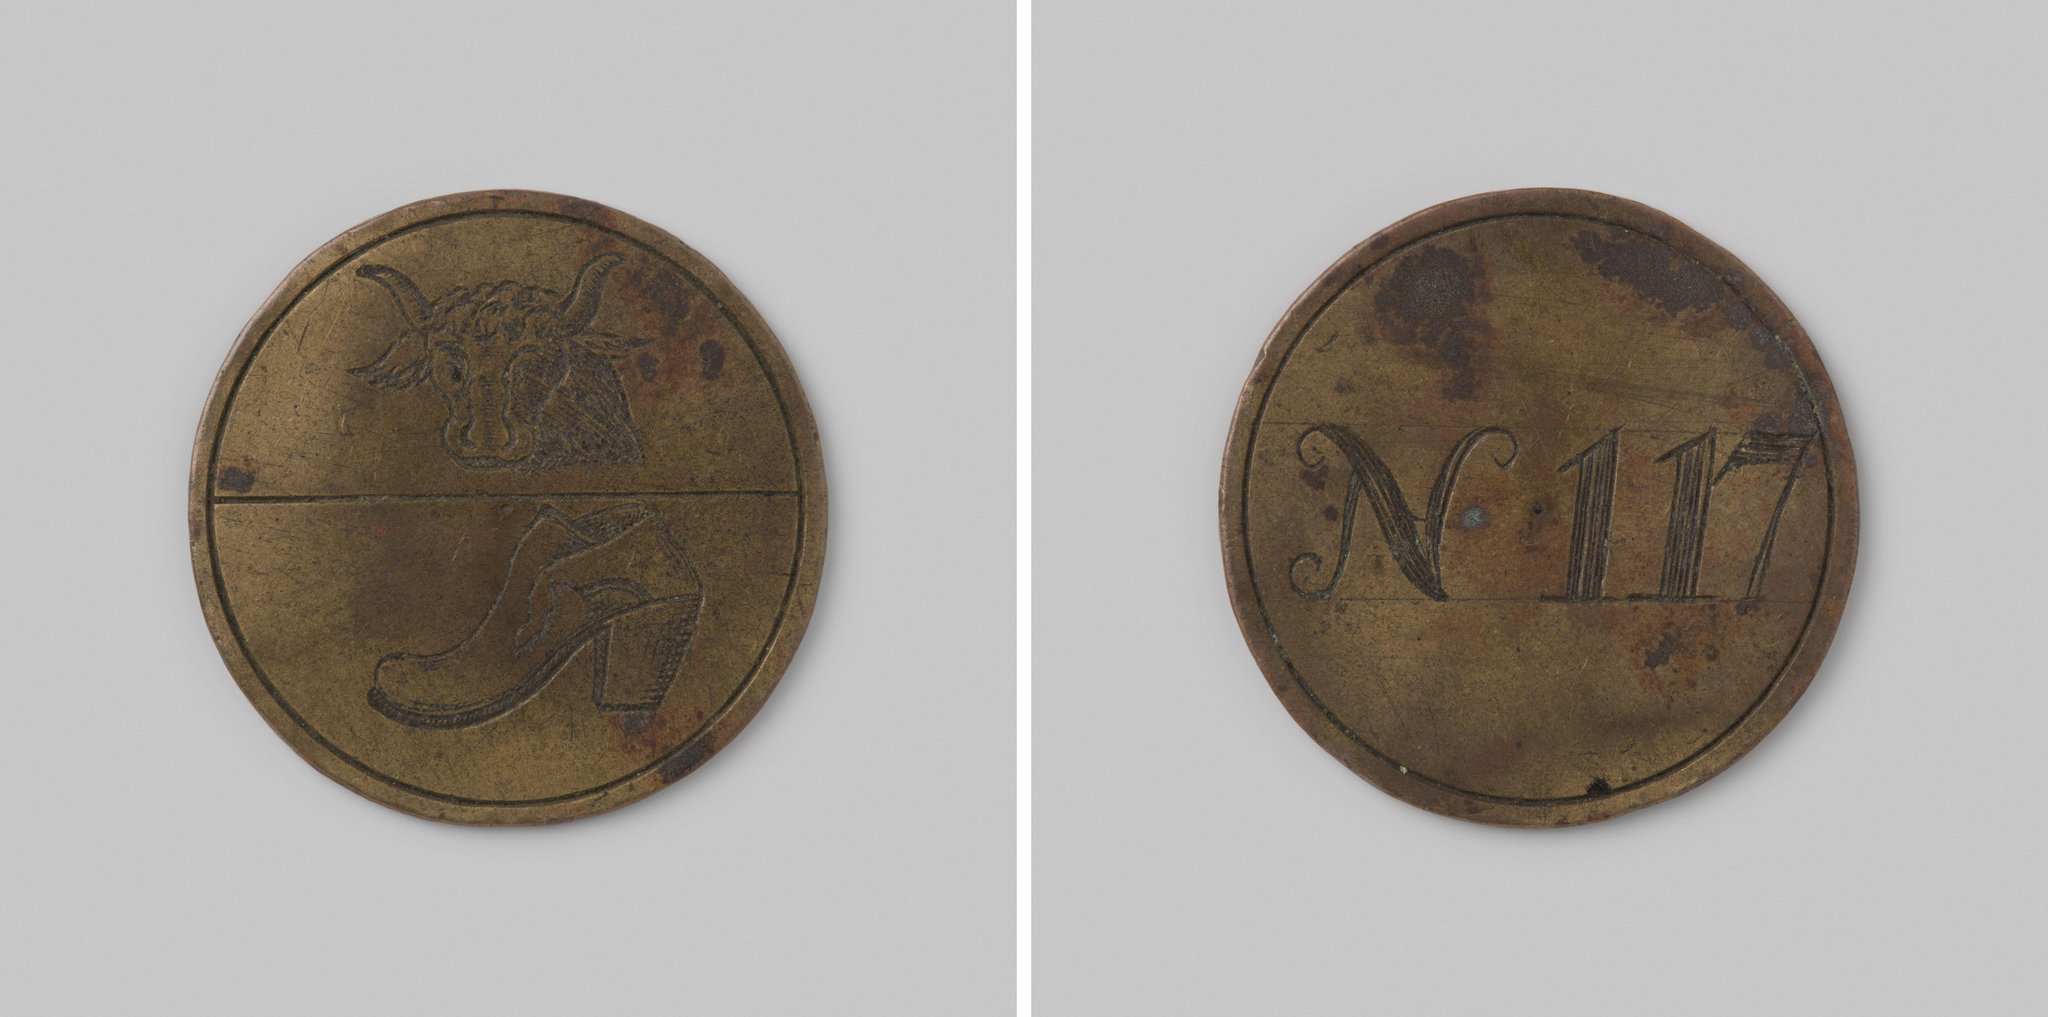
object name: history medal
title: Presentiepenning van het Huidenkopers-, Looiers- en Schoenmakersgilde te Amsterdam 1664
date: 1664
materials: brass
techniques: engraving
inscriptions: inscription: ‘N°.117’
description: Ronde messing plaat gegraveerd op de voorzijde een ossenkop boven een schoen, op de keerzijde nummer 117.